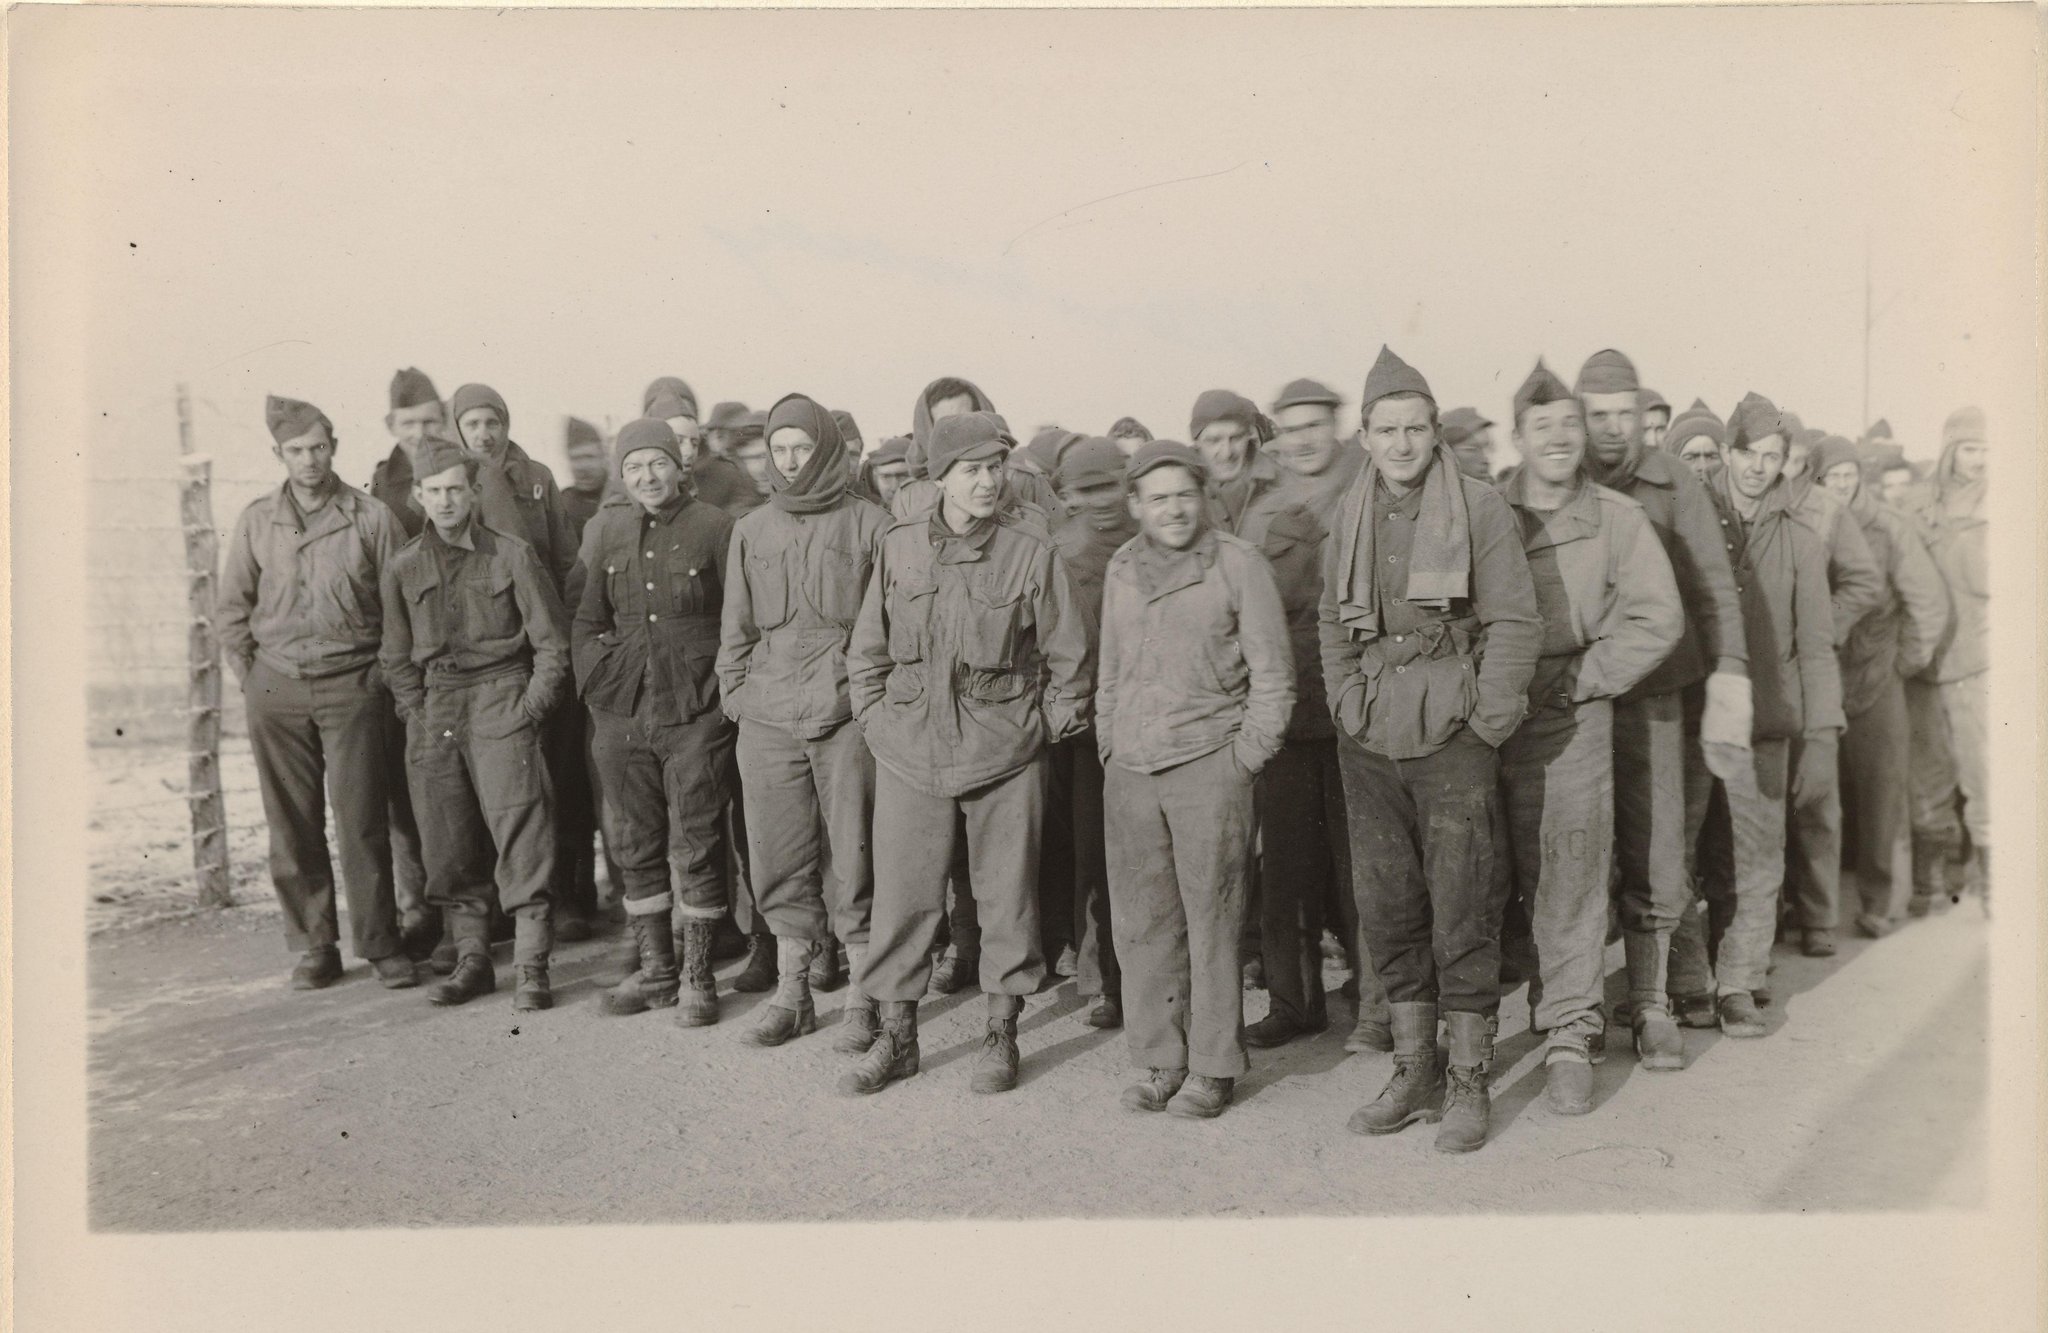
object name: photograph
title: Amerikaanse krijgsgevangenen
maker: dick w.b. van maarseveen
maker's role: fotograaf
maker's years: 1905-1990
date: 1944-1945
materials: photographic support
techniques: gelatin silver print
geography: muhlberg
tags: dick w.b. van maarseveen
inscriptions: inscription: ‘Amerikanen’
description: Klandestiene foto van Amerikaanse krijgsgevangenen na het Ardennenoffensief in december 1944 gepakt door de Duitsers. Onderdeel van een groep foto's gemaakt door Dick van Maarseveen in het Duitse krijgsgevangenenkamp Stalag IV B in Mühlberg in de periode 1943-1945.